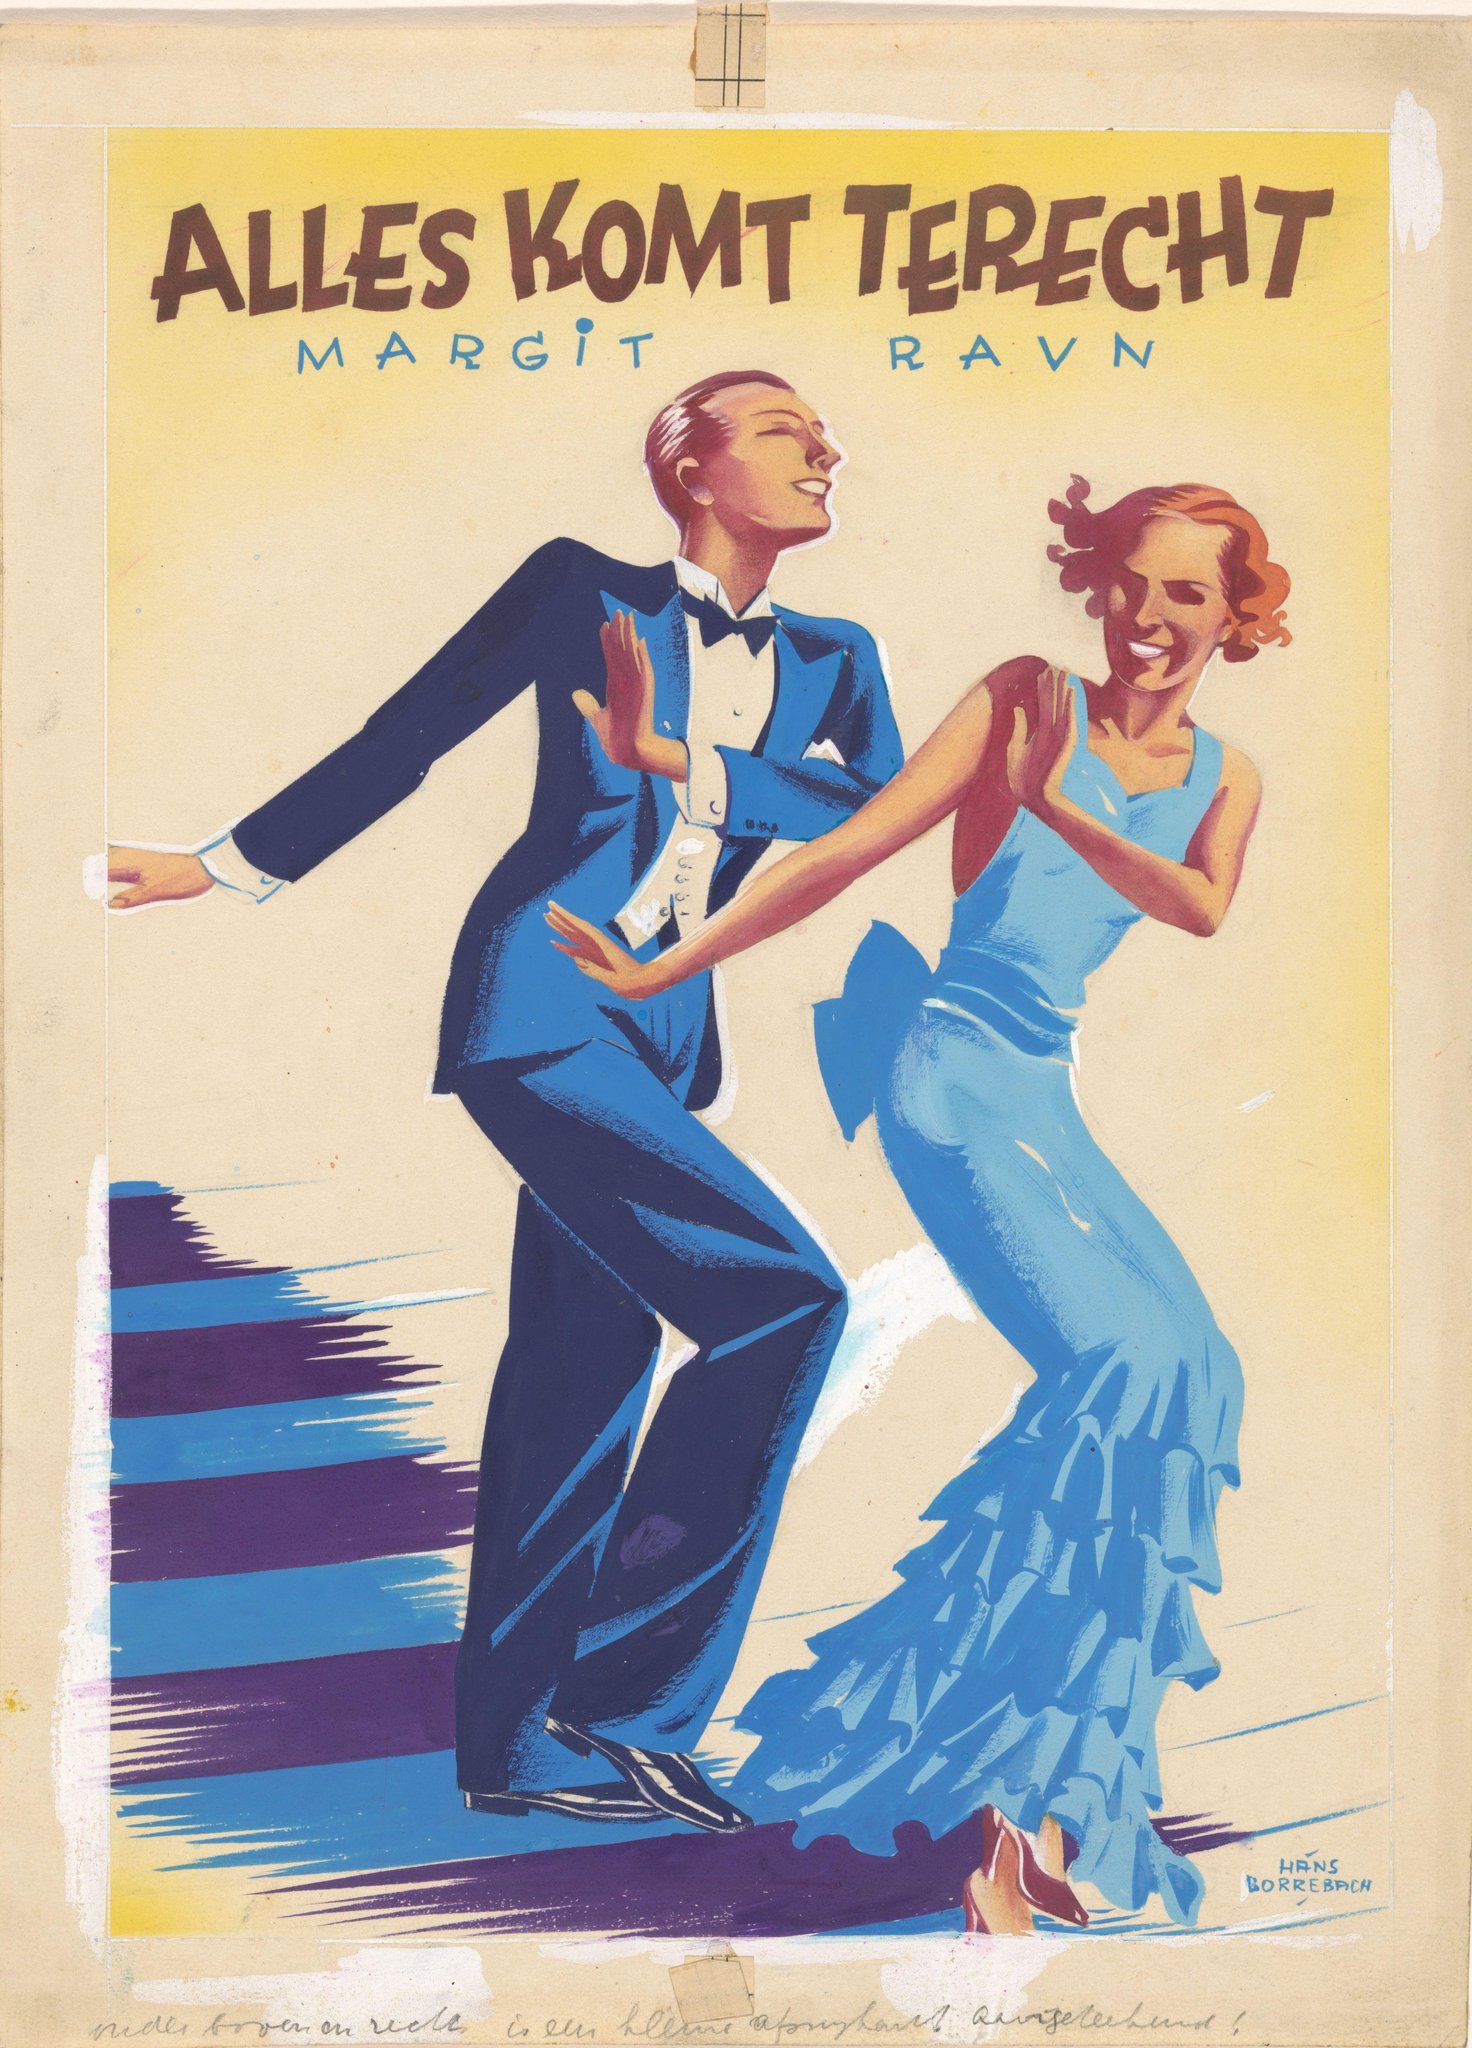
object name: study for binding design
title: Bandontwerp voor: Margit Ravn, Alles komt terecht (min søster og din søster), 1937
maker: hans borrebach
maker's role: draughtsman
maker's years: 1903-1991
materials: paint, paper, watercolor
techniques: brush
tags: dress, gown: evening dress (+ women's clothes), dancing, smiling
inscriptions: :, signature: ‘HANS/ BORREBACH’, collector's mark: Lugt 2228a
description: Een lachende jonge man en vrouw in avondkleding dansen dezelfde pas. De vrouw staat schuin voor de man op de gestreepte dansvloer.